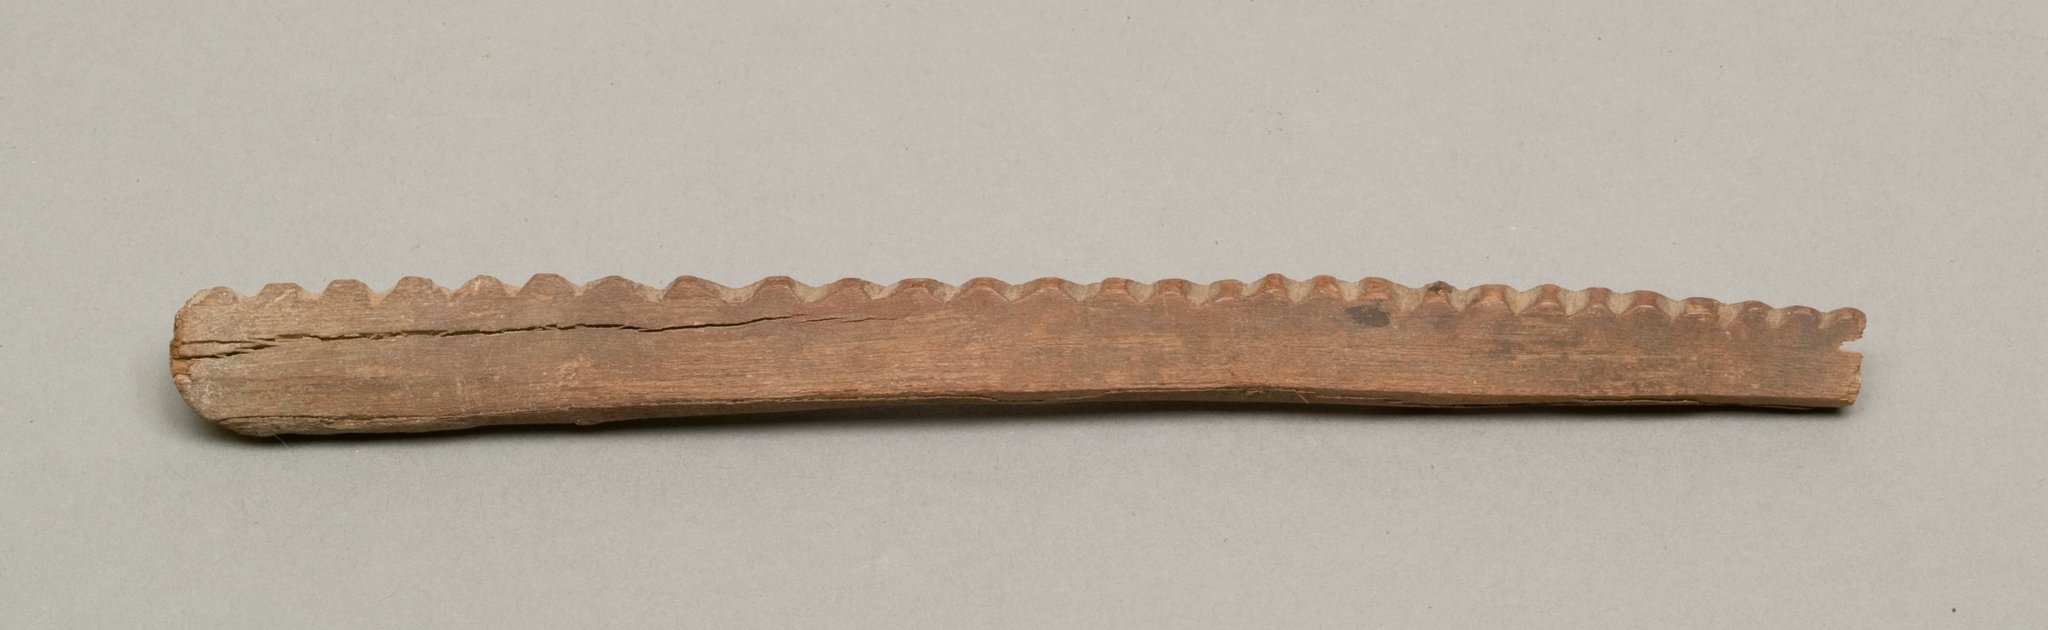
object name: weaving tool, warp spacer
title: Warp spacer ?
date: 1295-1070 BCE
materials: wood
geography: egypt